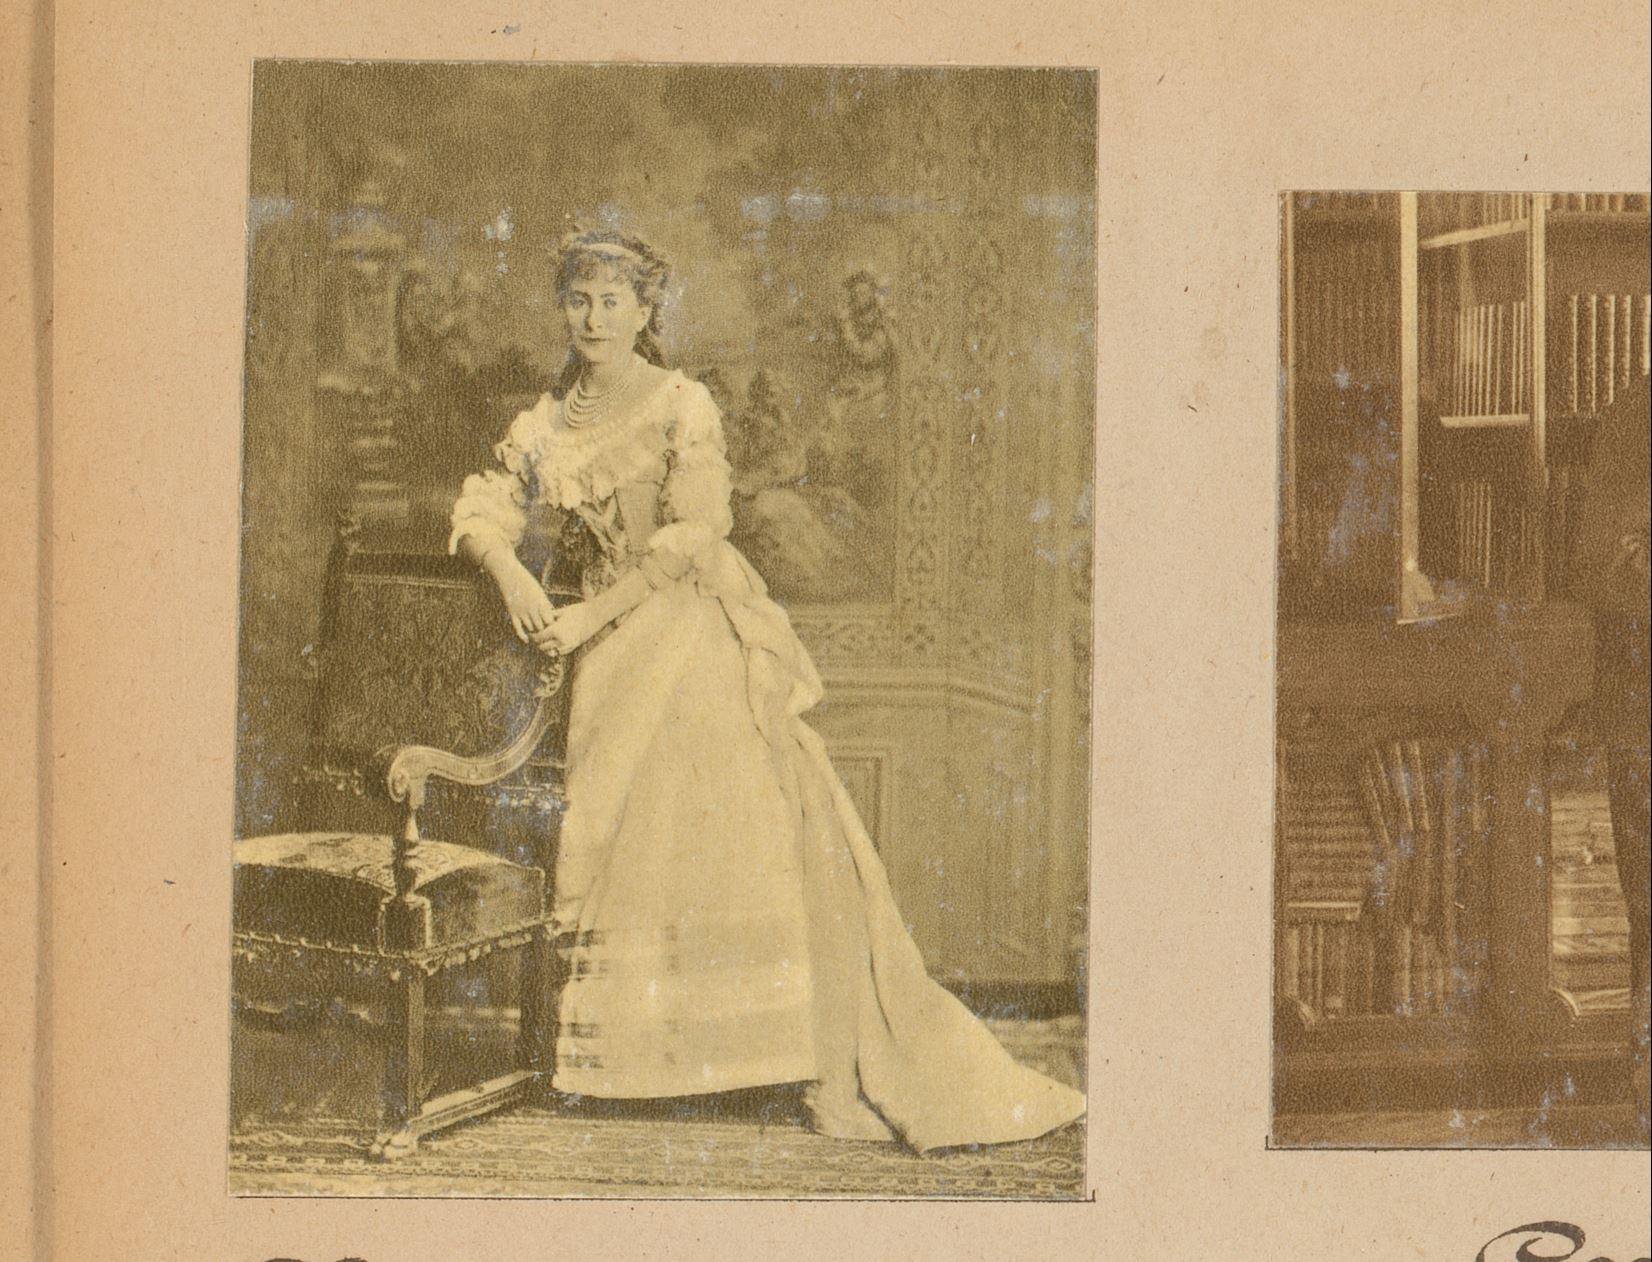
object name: album leaf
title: Portret van Suzanne Reichenberg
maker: Anonymous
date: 1883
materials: paper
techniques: rotogravure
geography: france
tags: portrait of actor, actress, france